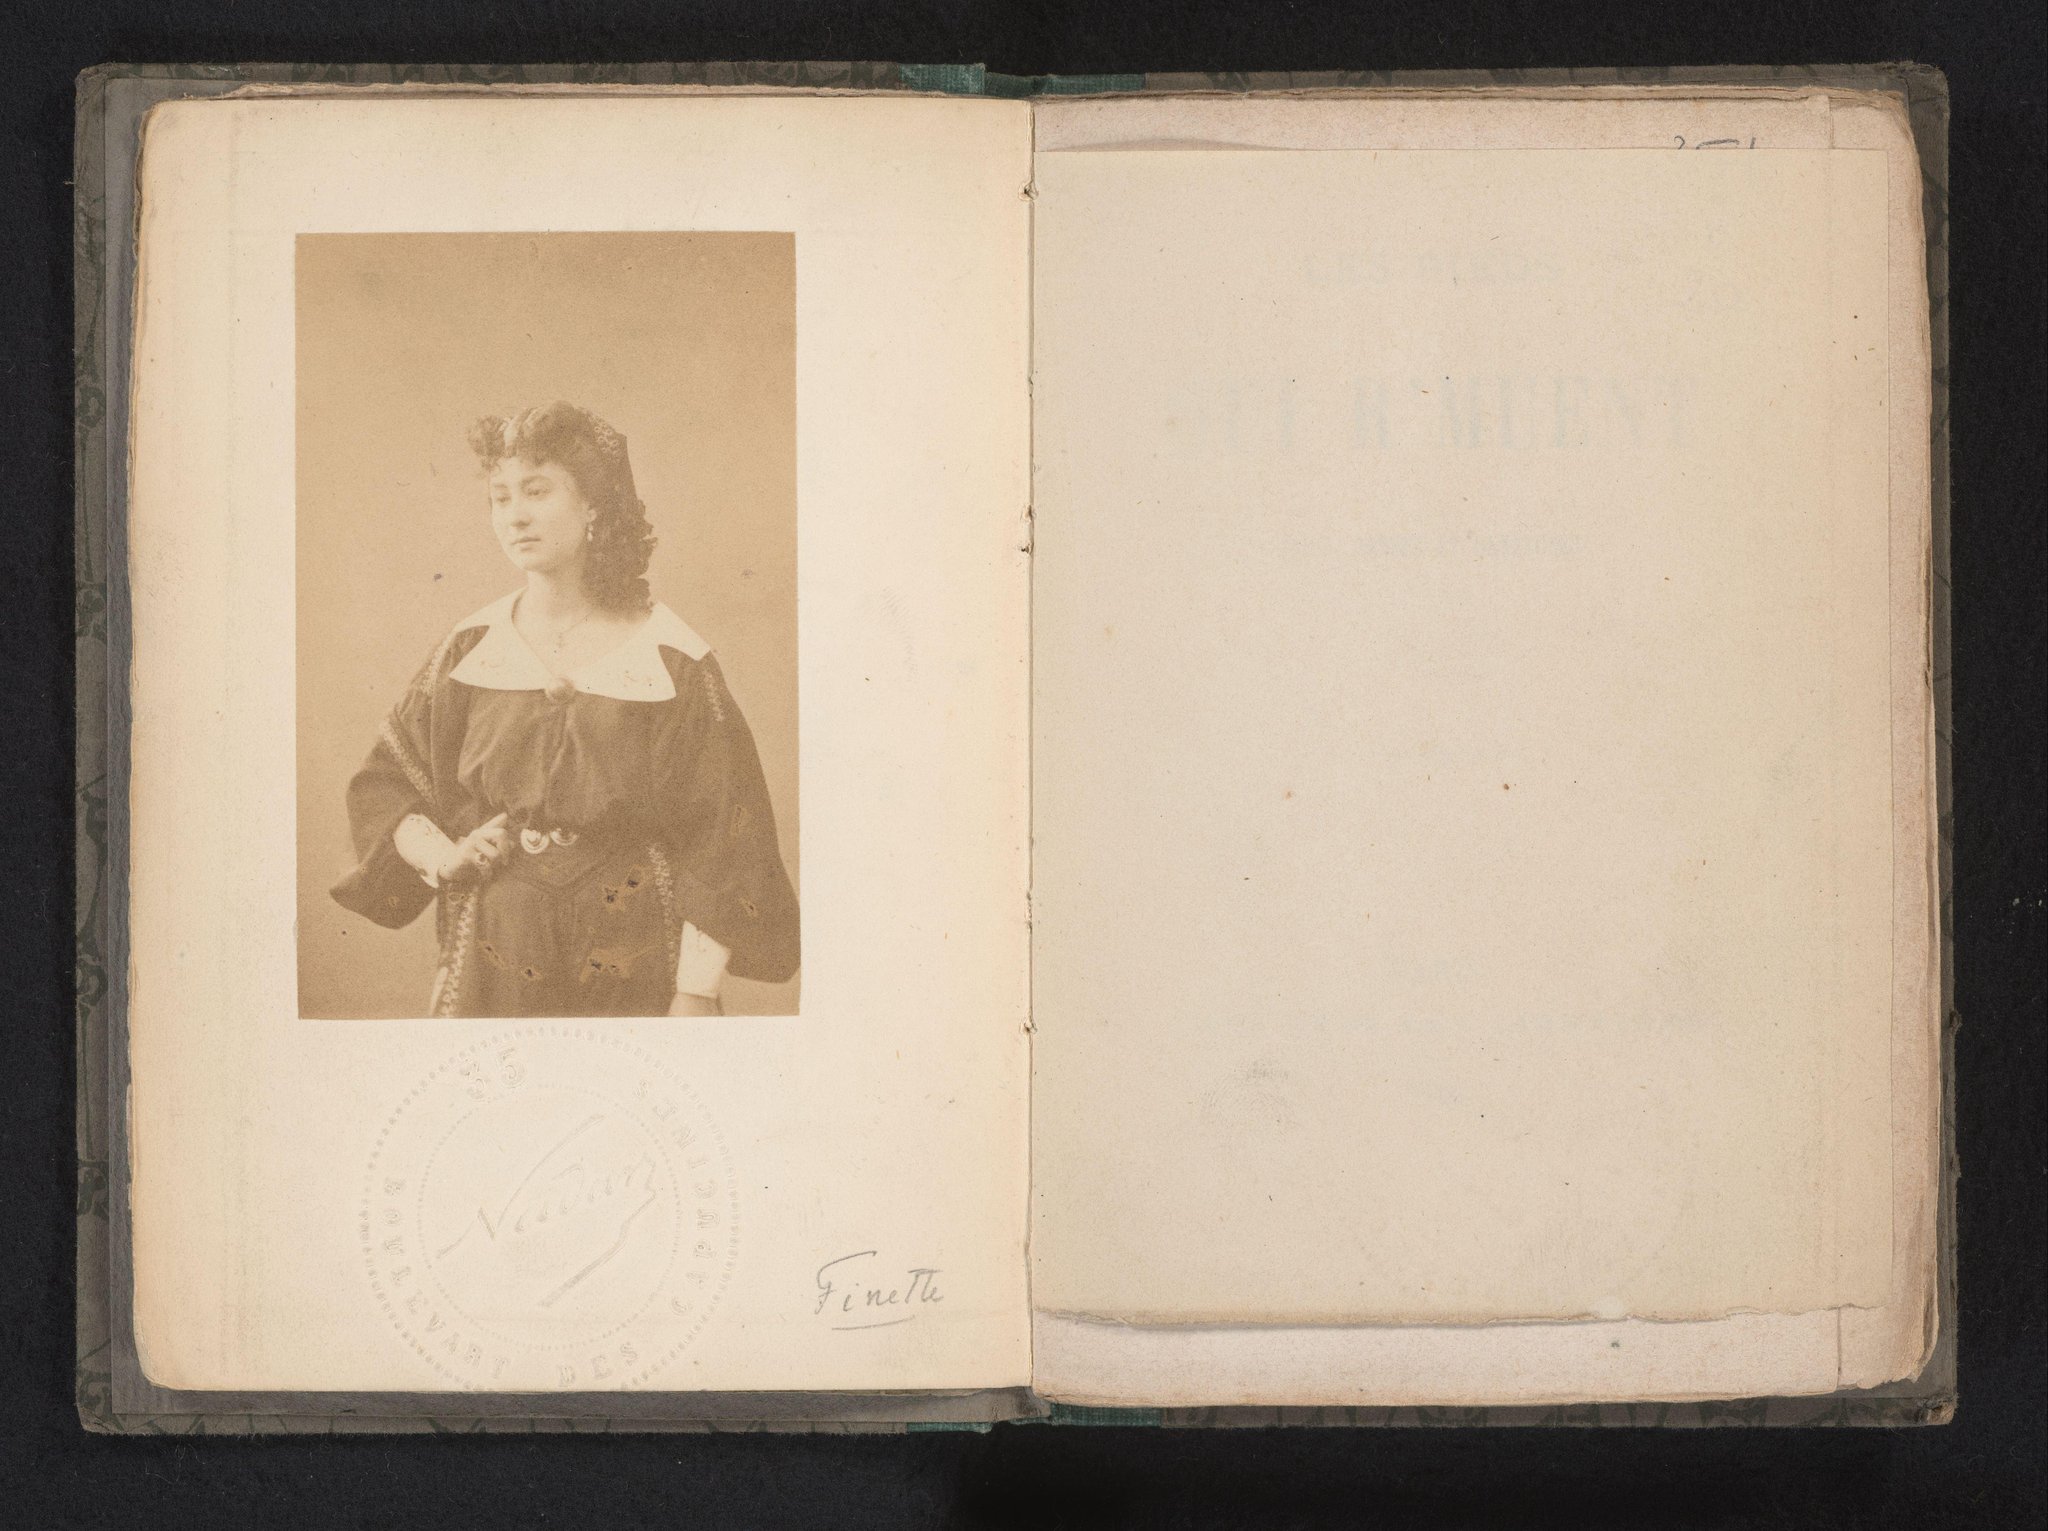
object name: photograph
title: Portret van Josephine Durwend als Finette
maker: félix nadar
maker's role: ballonvaarder, fotograaf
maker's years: 1820-1910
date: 1860-1863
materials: paper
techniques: albumen print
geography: paris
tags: portrait of dancer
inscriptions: address: ‘35/ BOULEVART DES CAPUCINES’